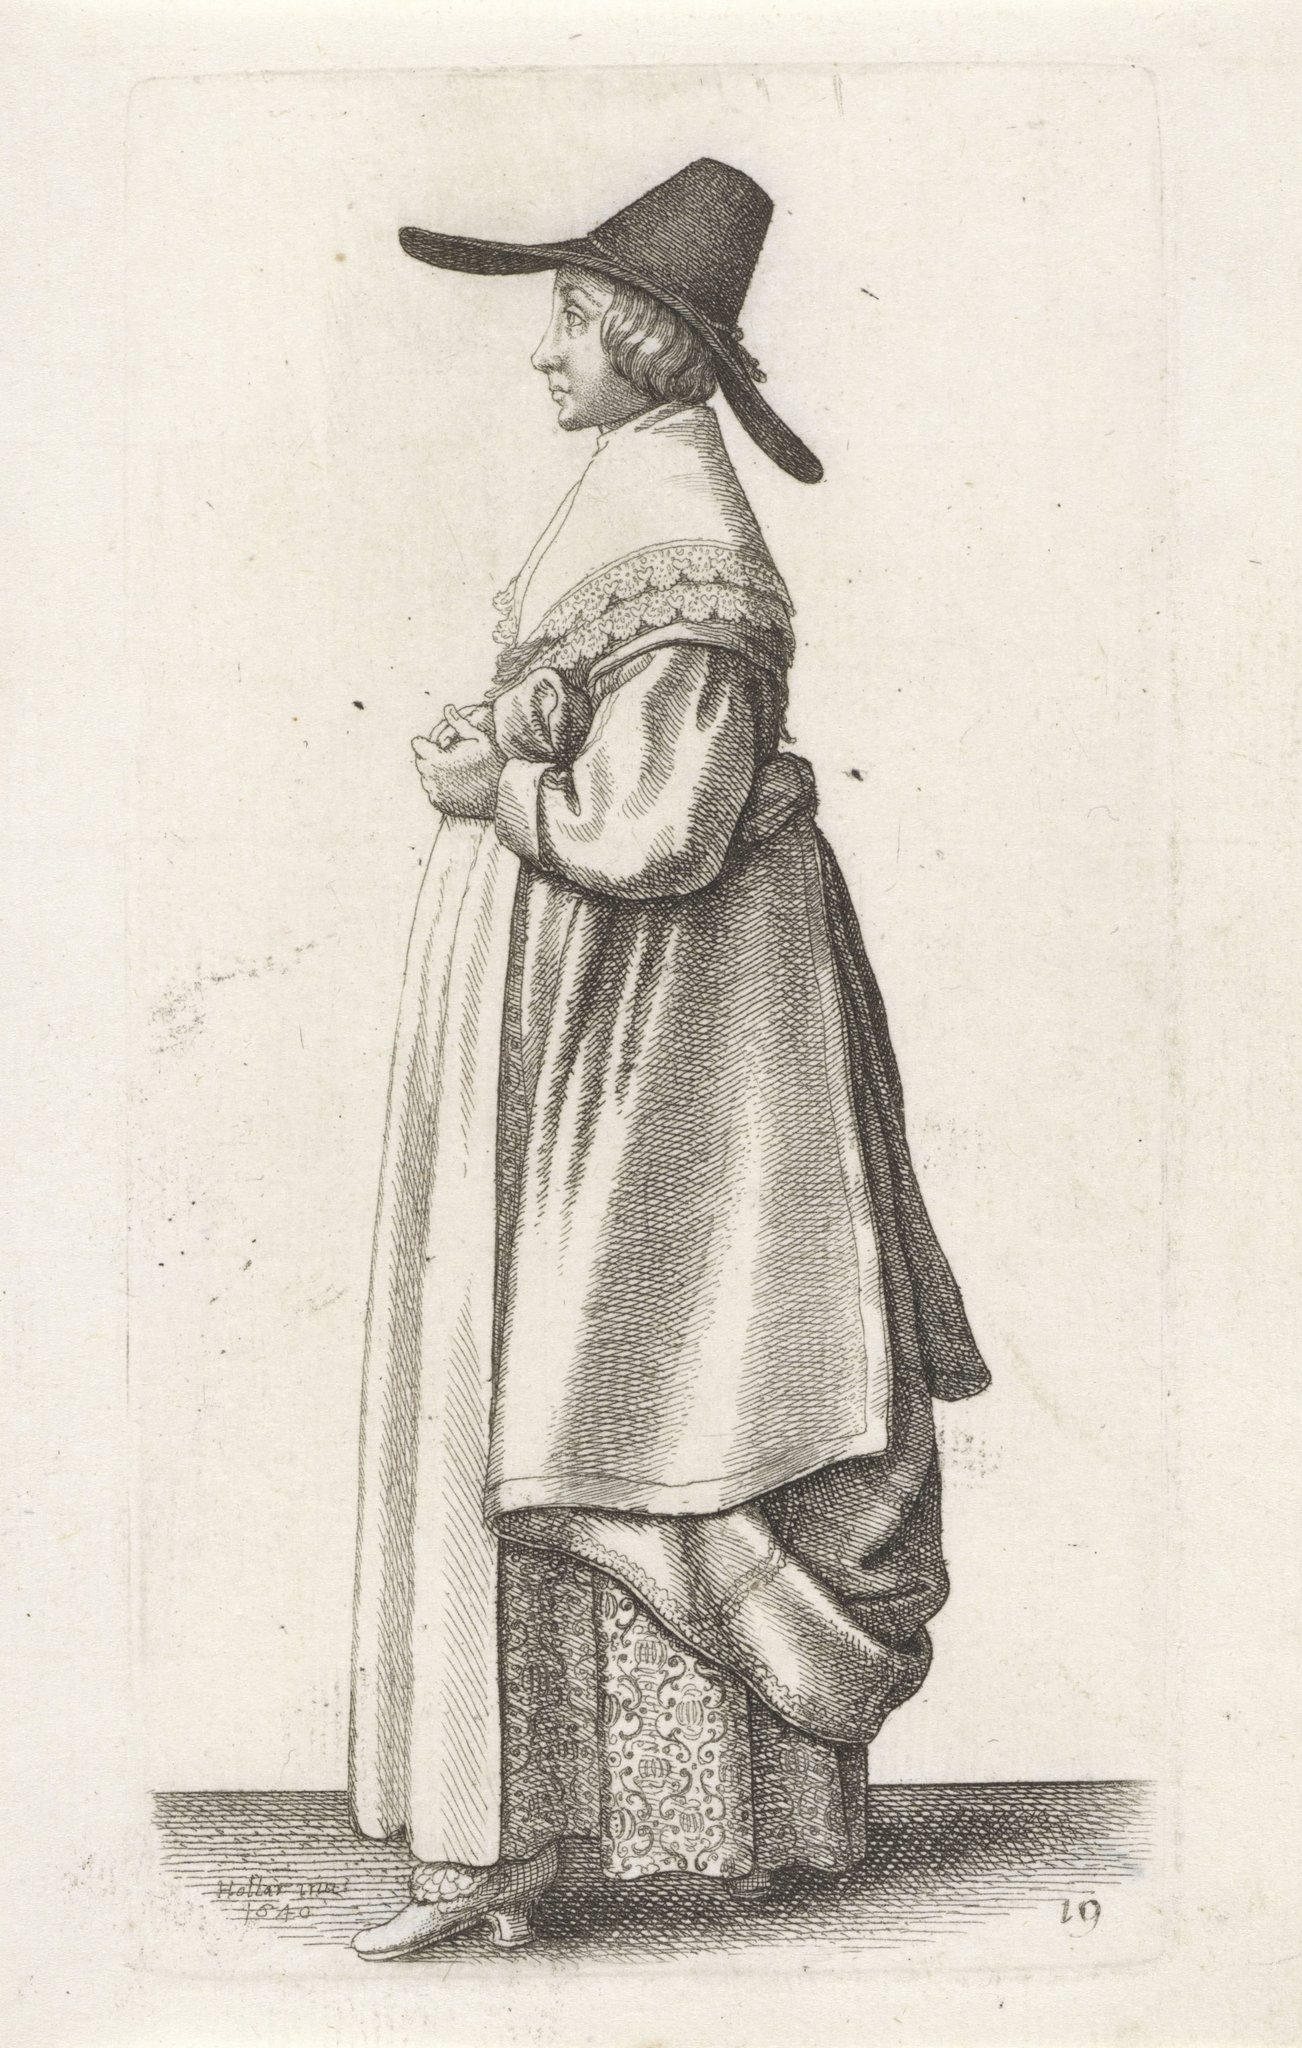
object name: costume print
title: Vrouwen gekleed volgens de Engelse mode, ca. 1640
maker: wenceslaus hollar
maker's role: draughtsman, print maker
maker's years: 1607-1677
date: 1640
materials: paper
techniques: etching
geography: london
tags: europeans: englishmen (+ women), neck-gear: collar (+ women's clothes), fashion plates, clothes, costume (+ women's clothes), head-gear: hat (+ women's clothes), shoes, sandals (+ women's clothes), dress, gown (+ women's clothes), england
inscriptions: collector's mark: Lugt 654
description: Engelse vrouw, in profiel naar links. Zij trekt haar overkleed onder de linkerarm omhoog, zodat het geborduurde onderkleed is te zien. Een hooggesloten kraag, afgezet met kant bedekt hals en schouders. Op het hoofd een taps toelopende hoed met koord om de bol en brede slappe rand. Schoenen met hakken, versierd met een rozet. No. 19 uit de serie Ornatus Muliebris Anglicanus.